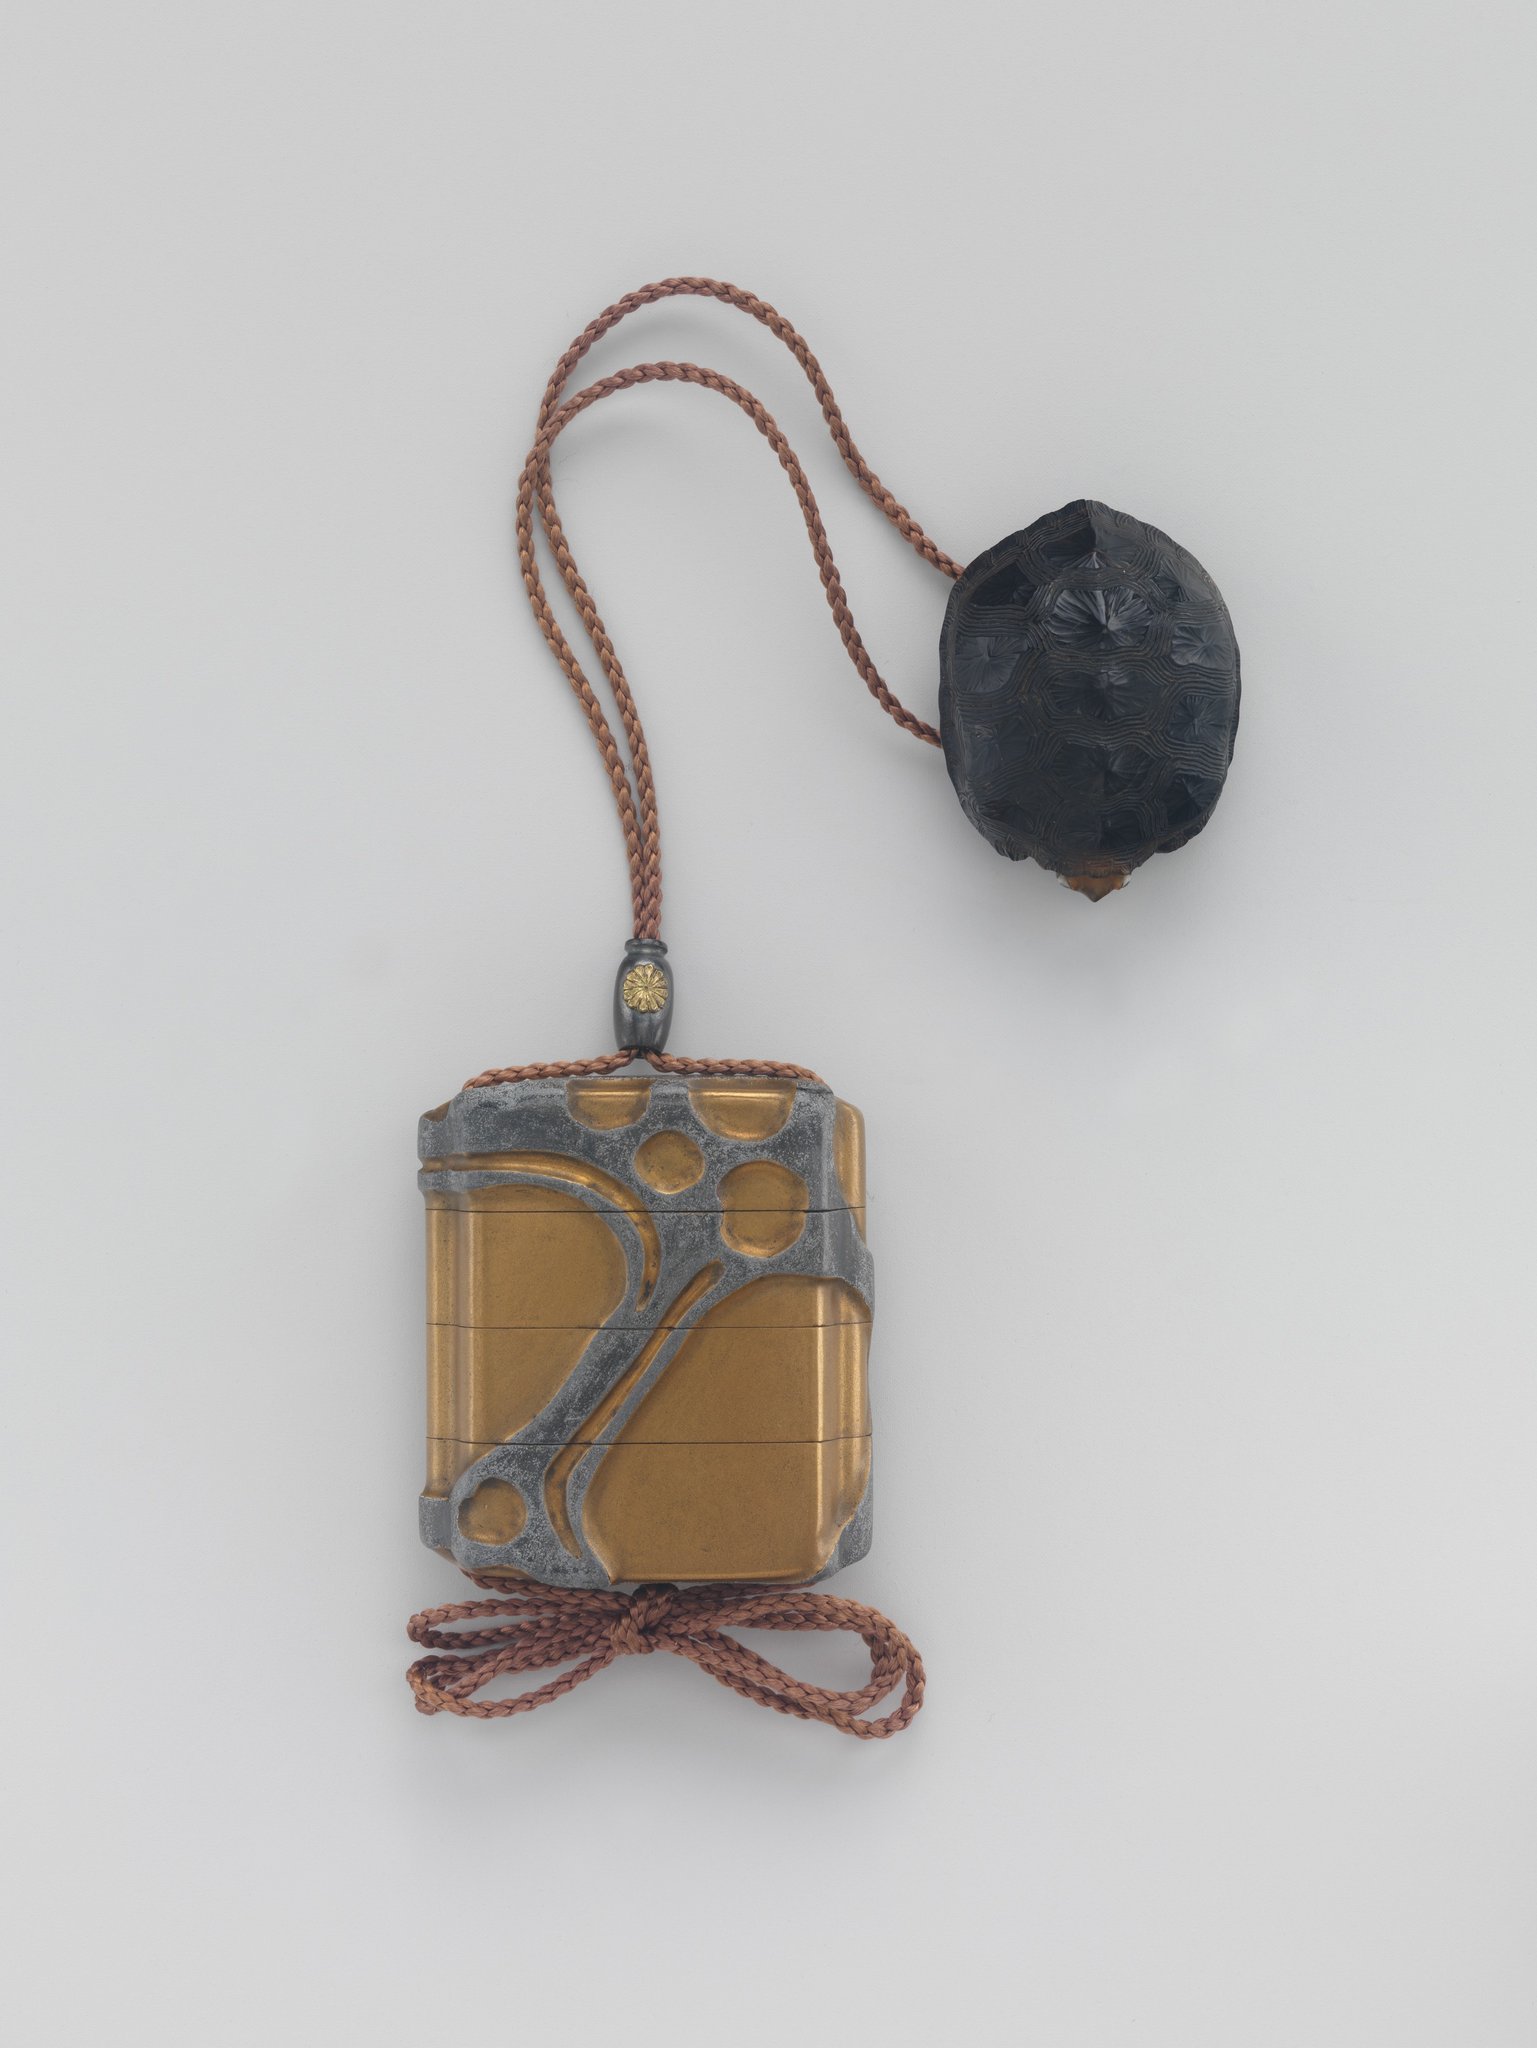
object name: inrō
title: Inrō with Stylized Waves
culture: japanese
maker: shibata zeshin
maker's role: artist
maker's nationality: japanese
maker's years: 1807-1891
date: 1801-1900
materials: bronze, gold, lacquer, pewter, shell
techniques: carving, inlay